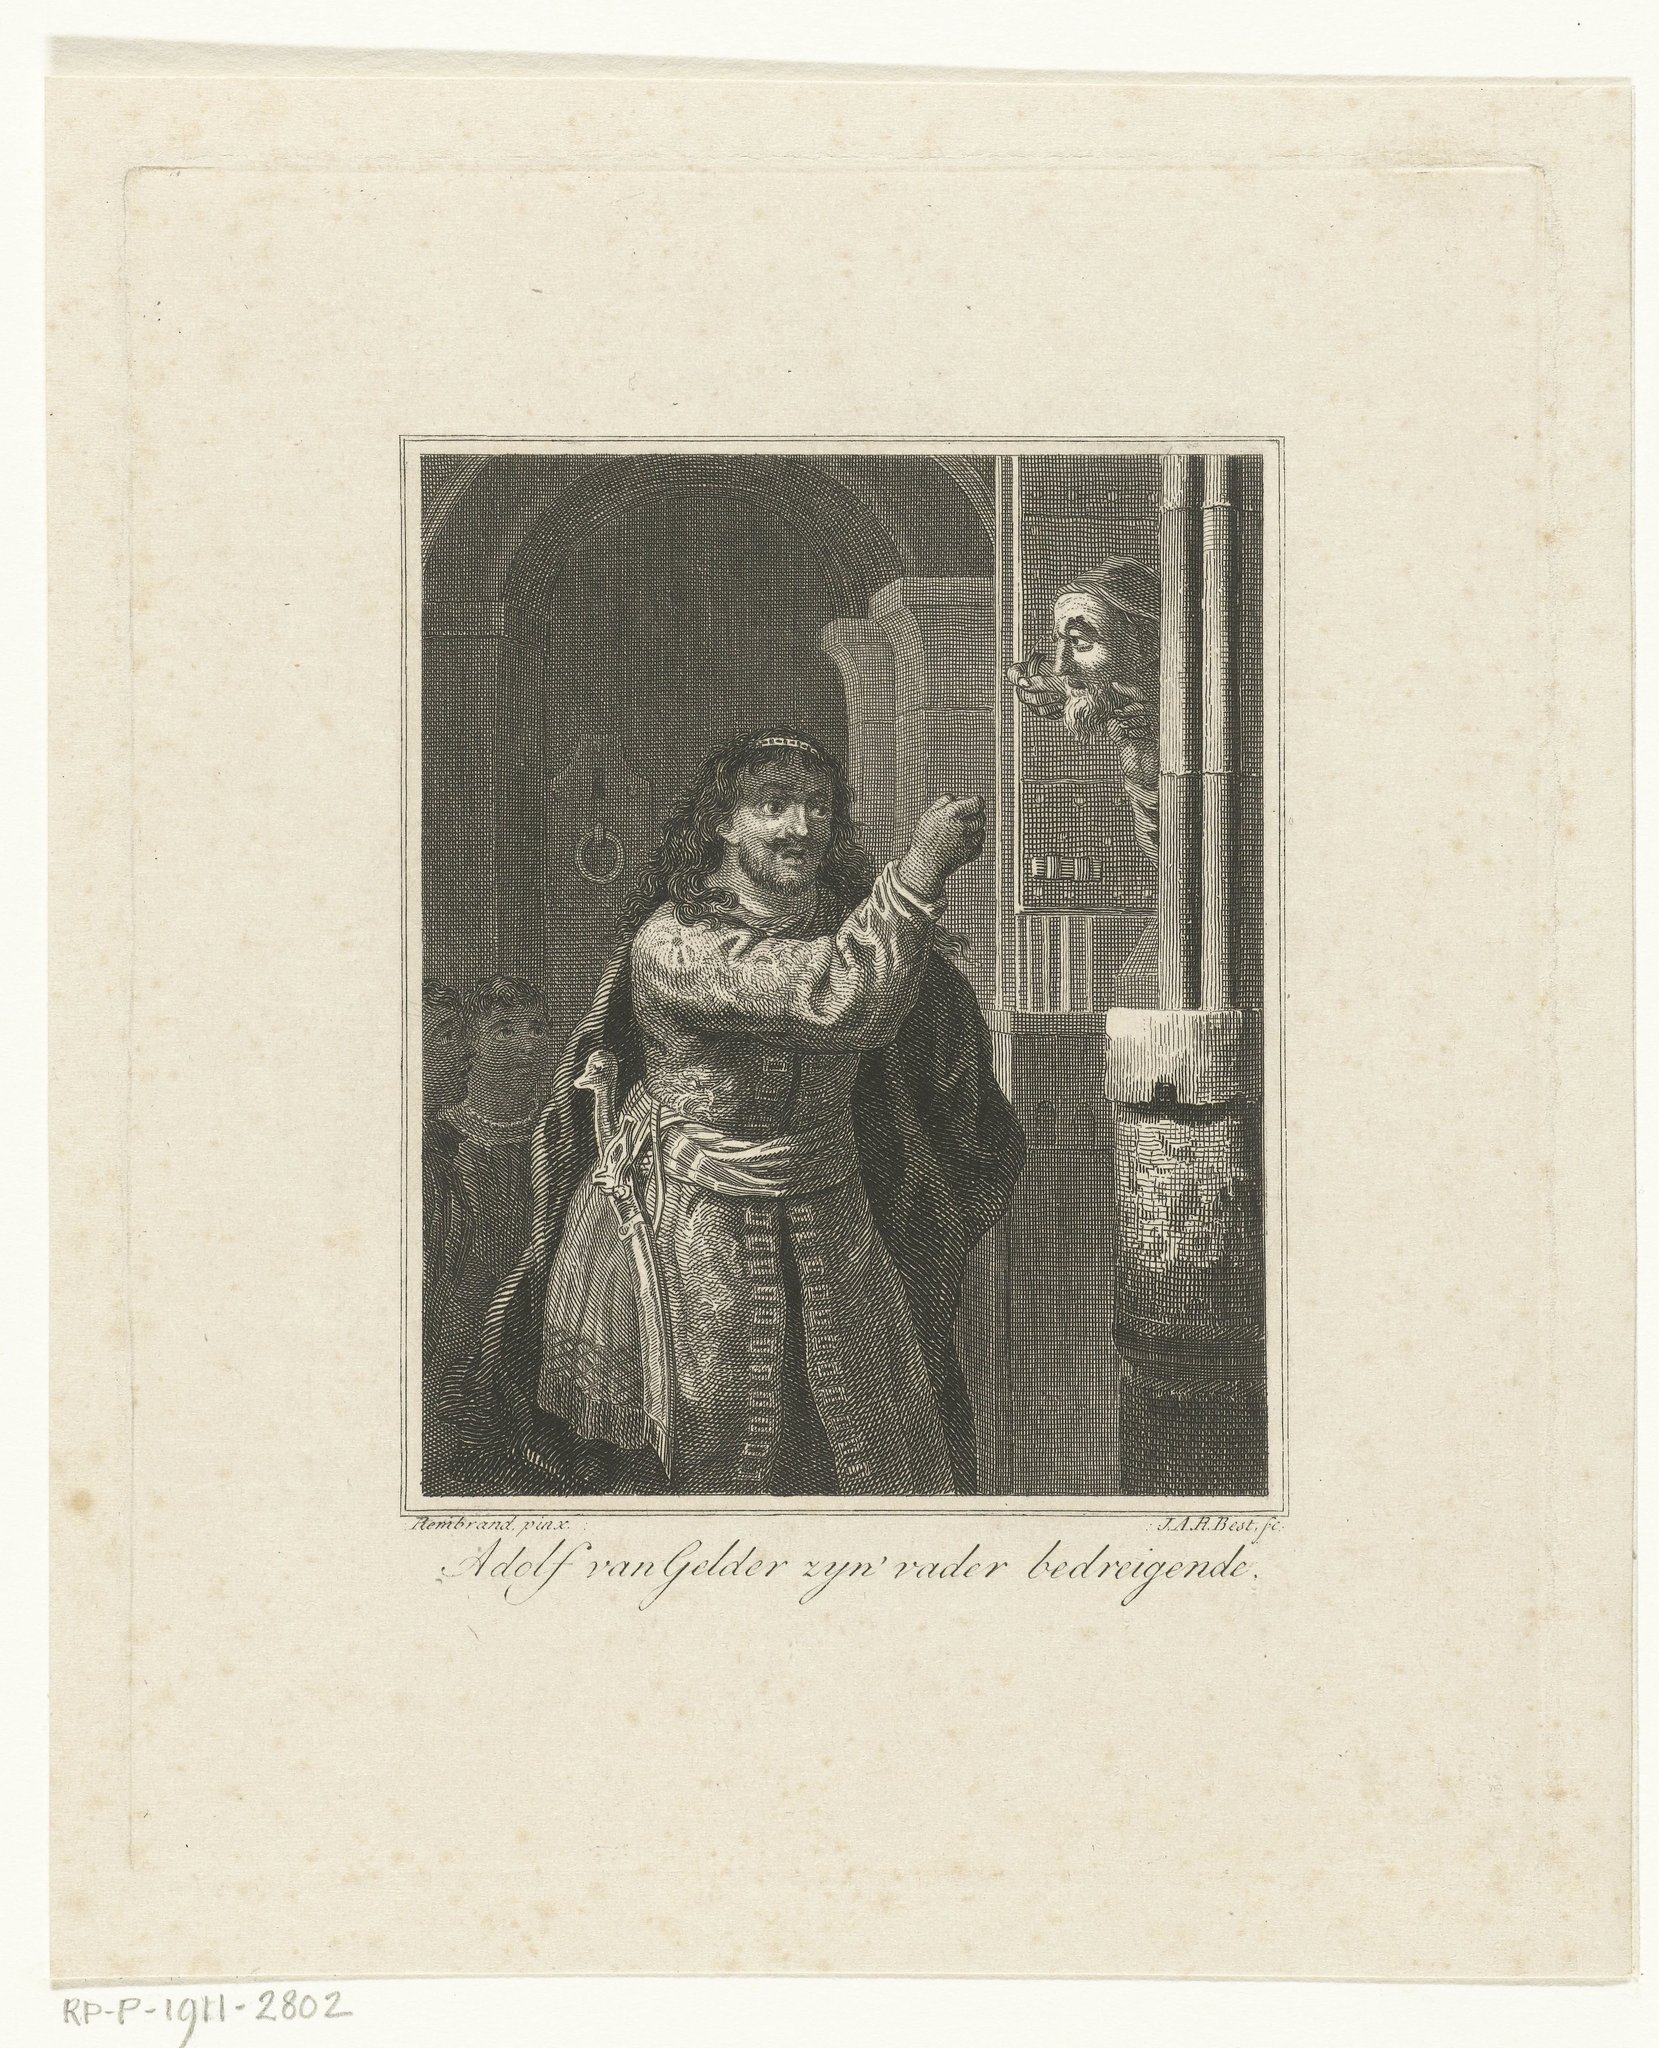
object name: print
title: Adolf van Gelder bedreigt zijn vader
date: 1807-1855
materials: paper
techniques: etching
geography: amsterdam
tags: threatening behaviour, challenging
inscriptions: collector's mark: Lugt 2228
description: Prent naar schilderij van Rembrandt Harmensz. van Rijn.